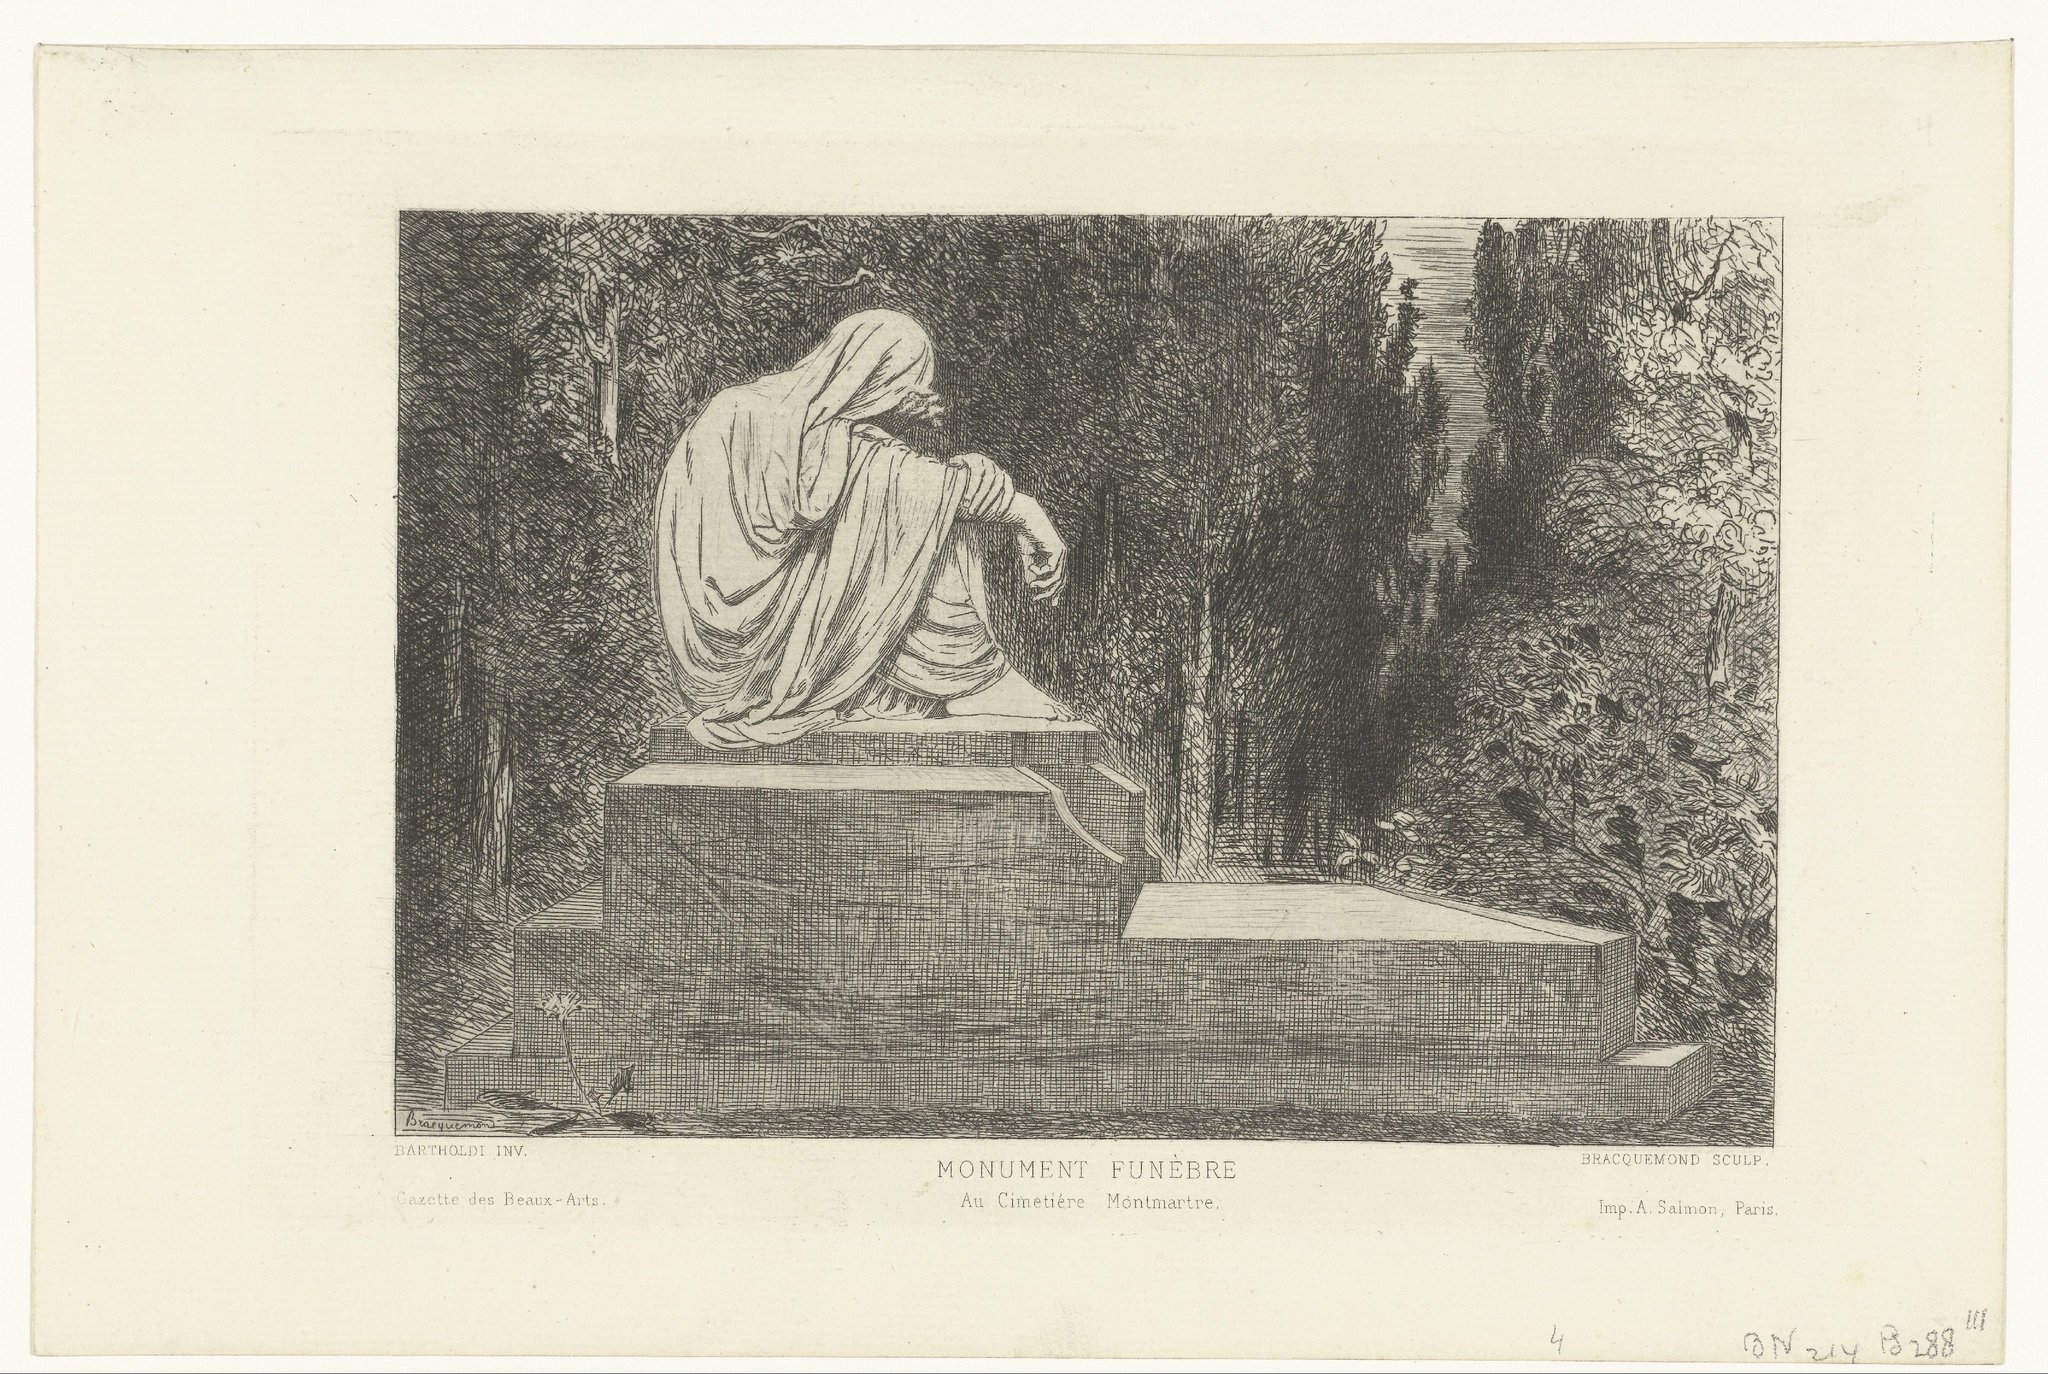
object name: print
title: Monument funèbre au Cimetière Montmartre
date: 1860-1867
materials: paper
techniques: etching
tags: grave, tomb, monument, statue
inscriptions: collector's mark: Lugt 2228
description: Grafmonument met beeld van zittende figuur door Frédéric Auguste Bartholdi op de begraafplaats van Montmartre